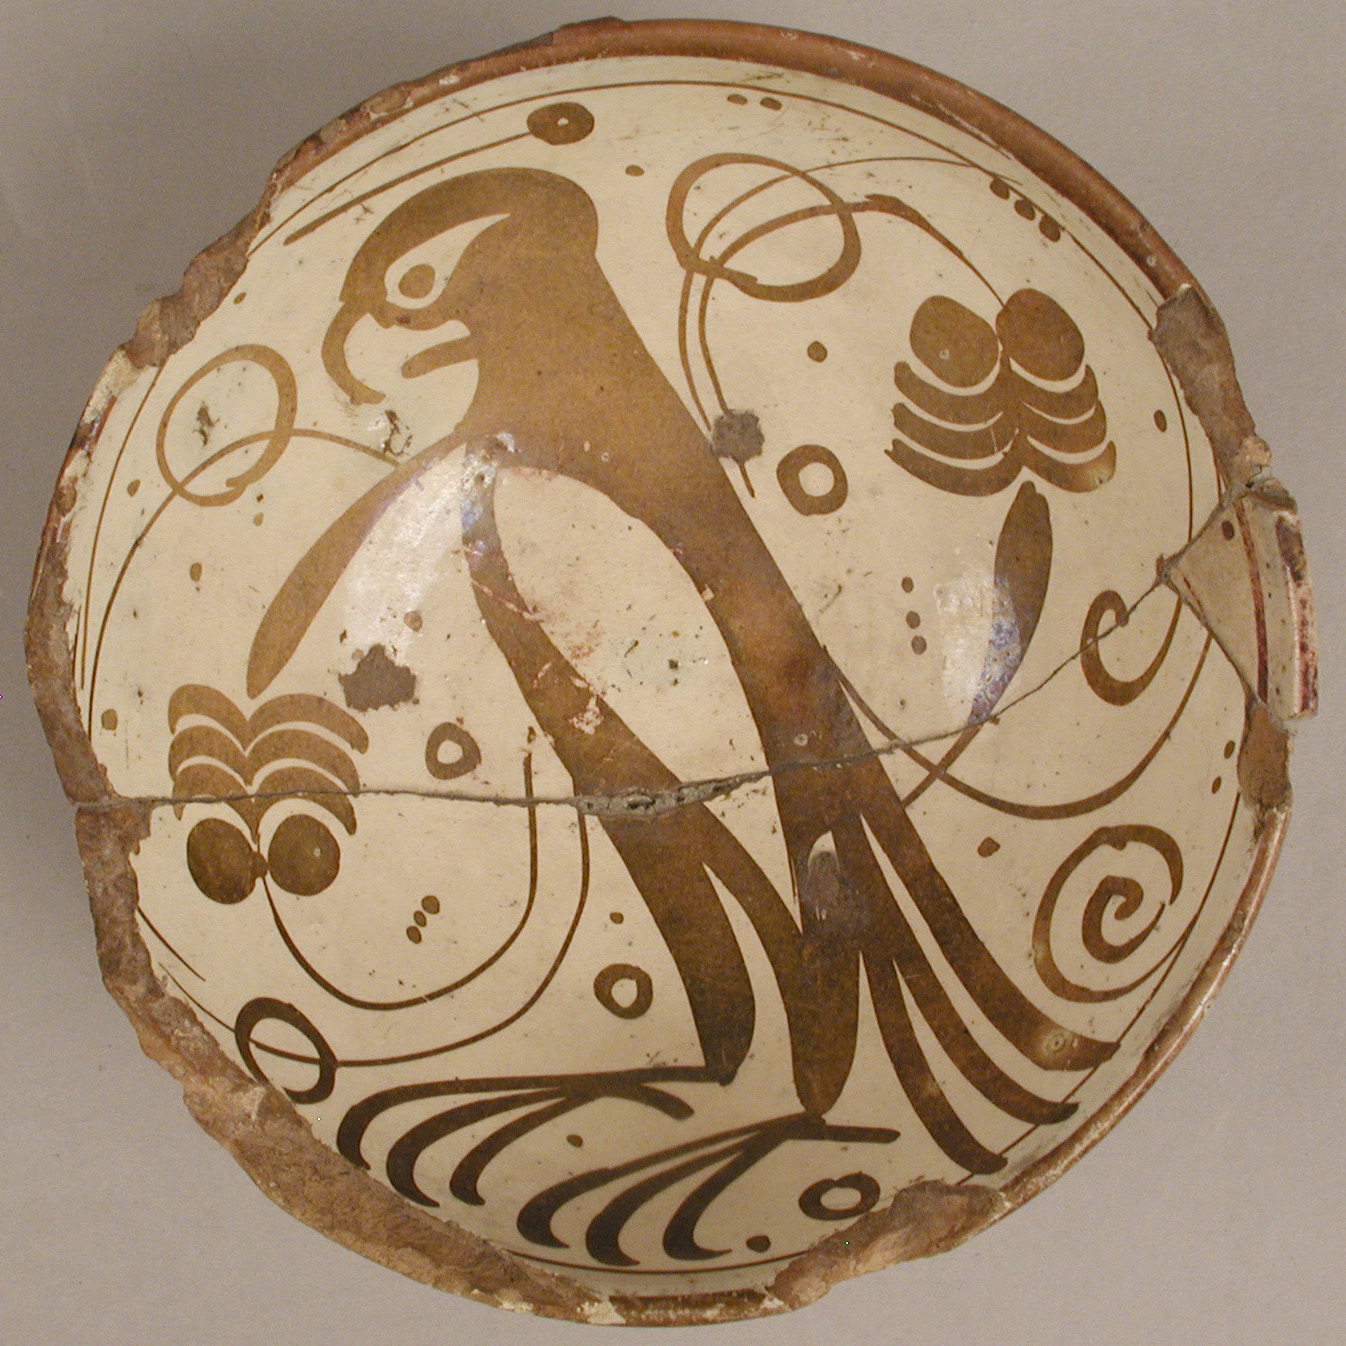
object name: bowl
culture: spanish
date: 1467-1500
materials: earthenware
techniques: glazing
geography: spain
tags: bowls